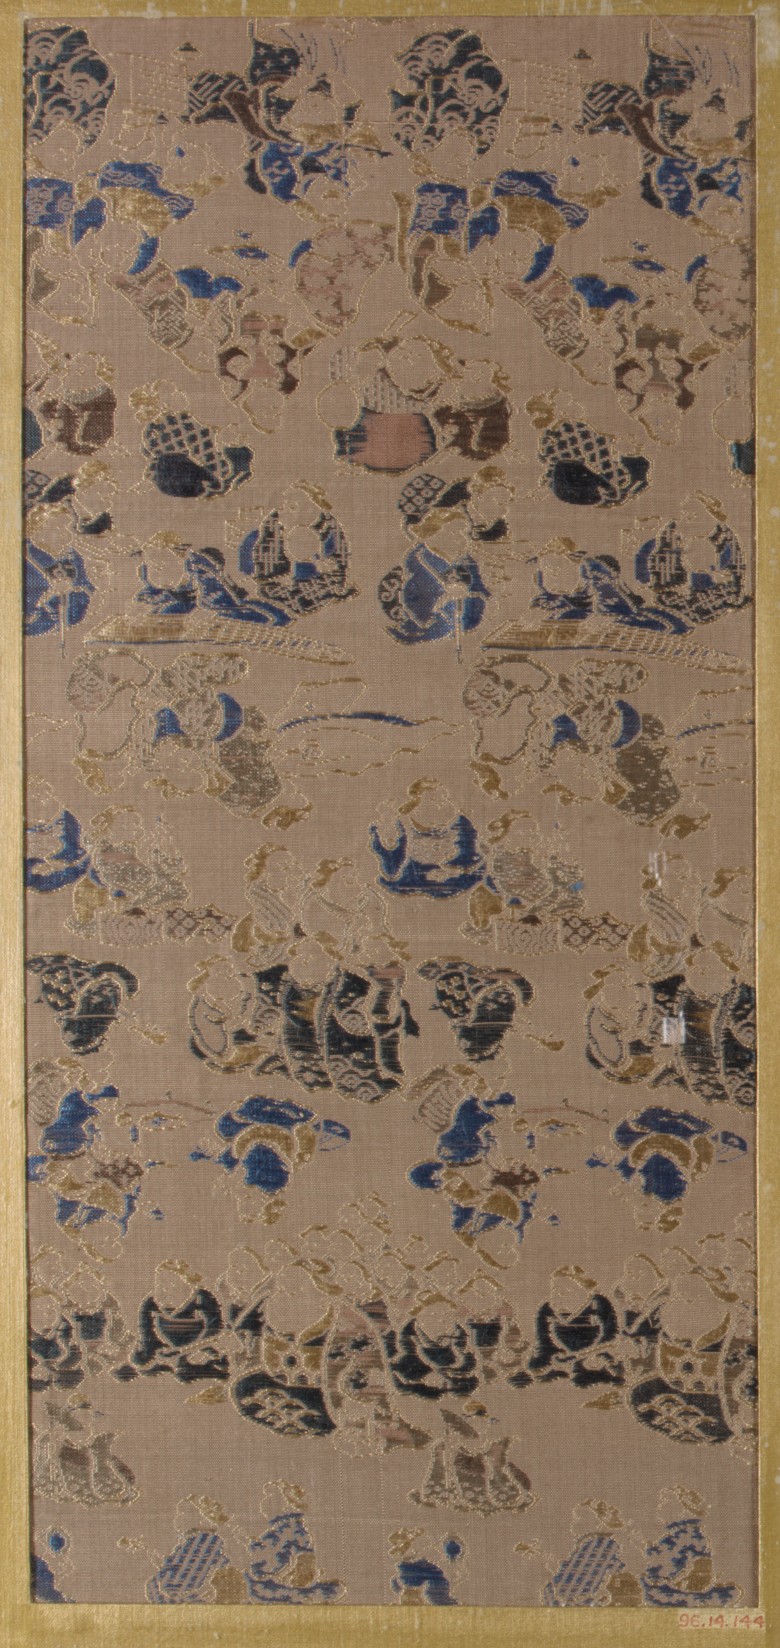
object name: piece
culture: japanese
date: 1801-1900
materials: silk